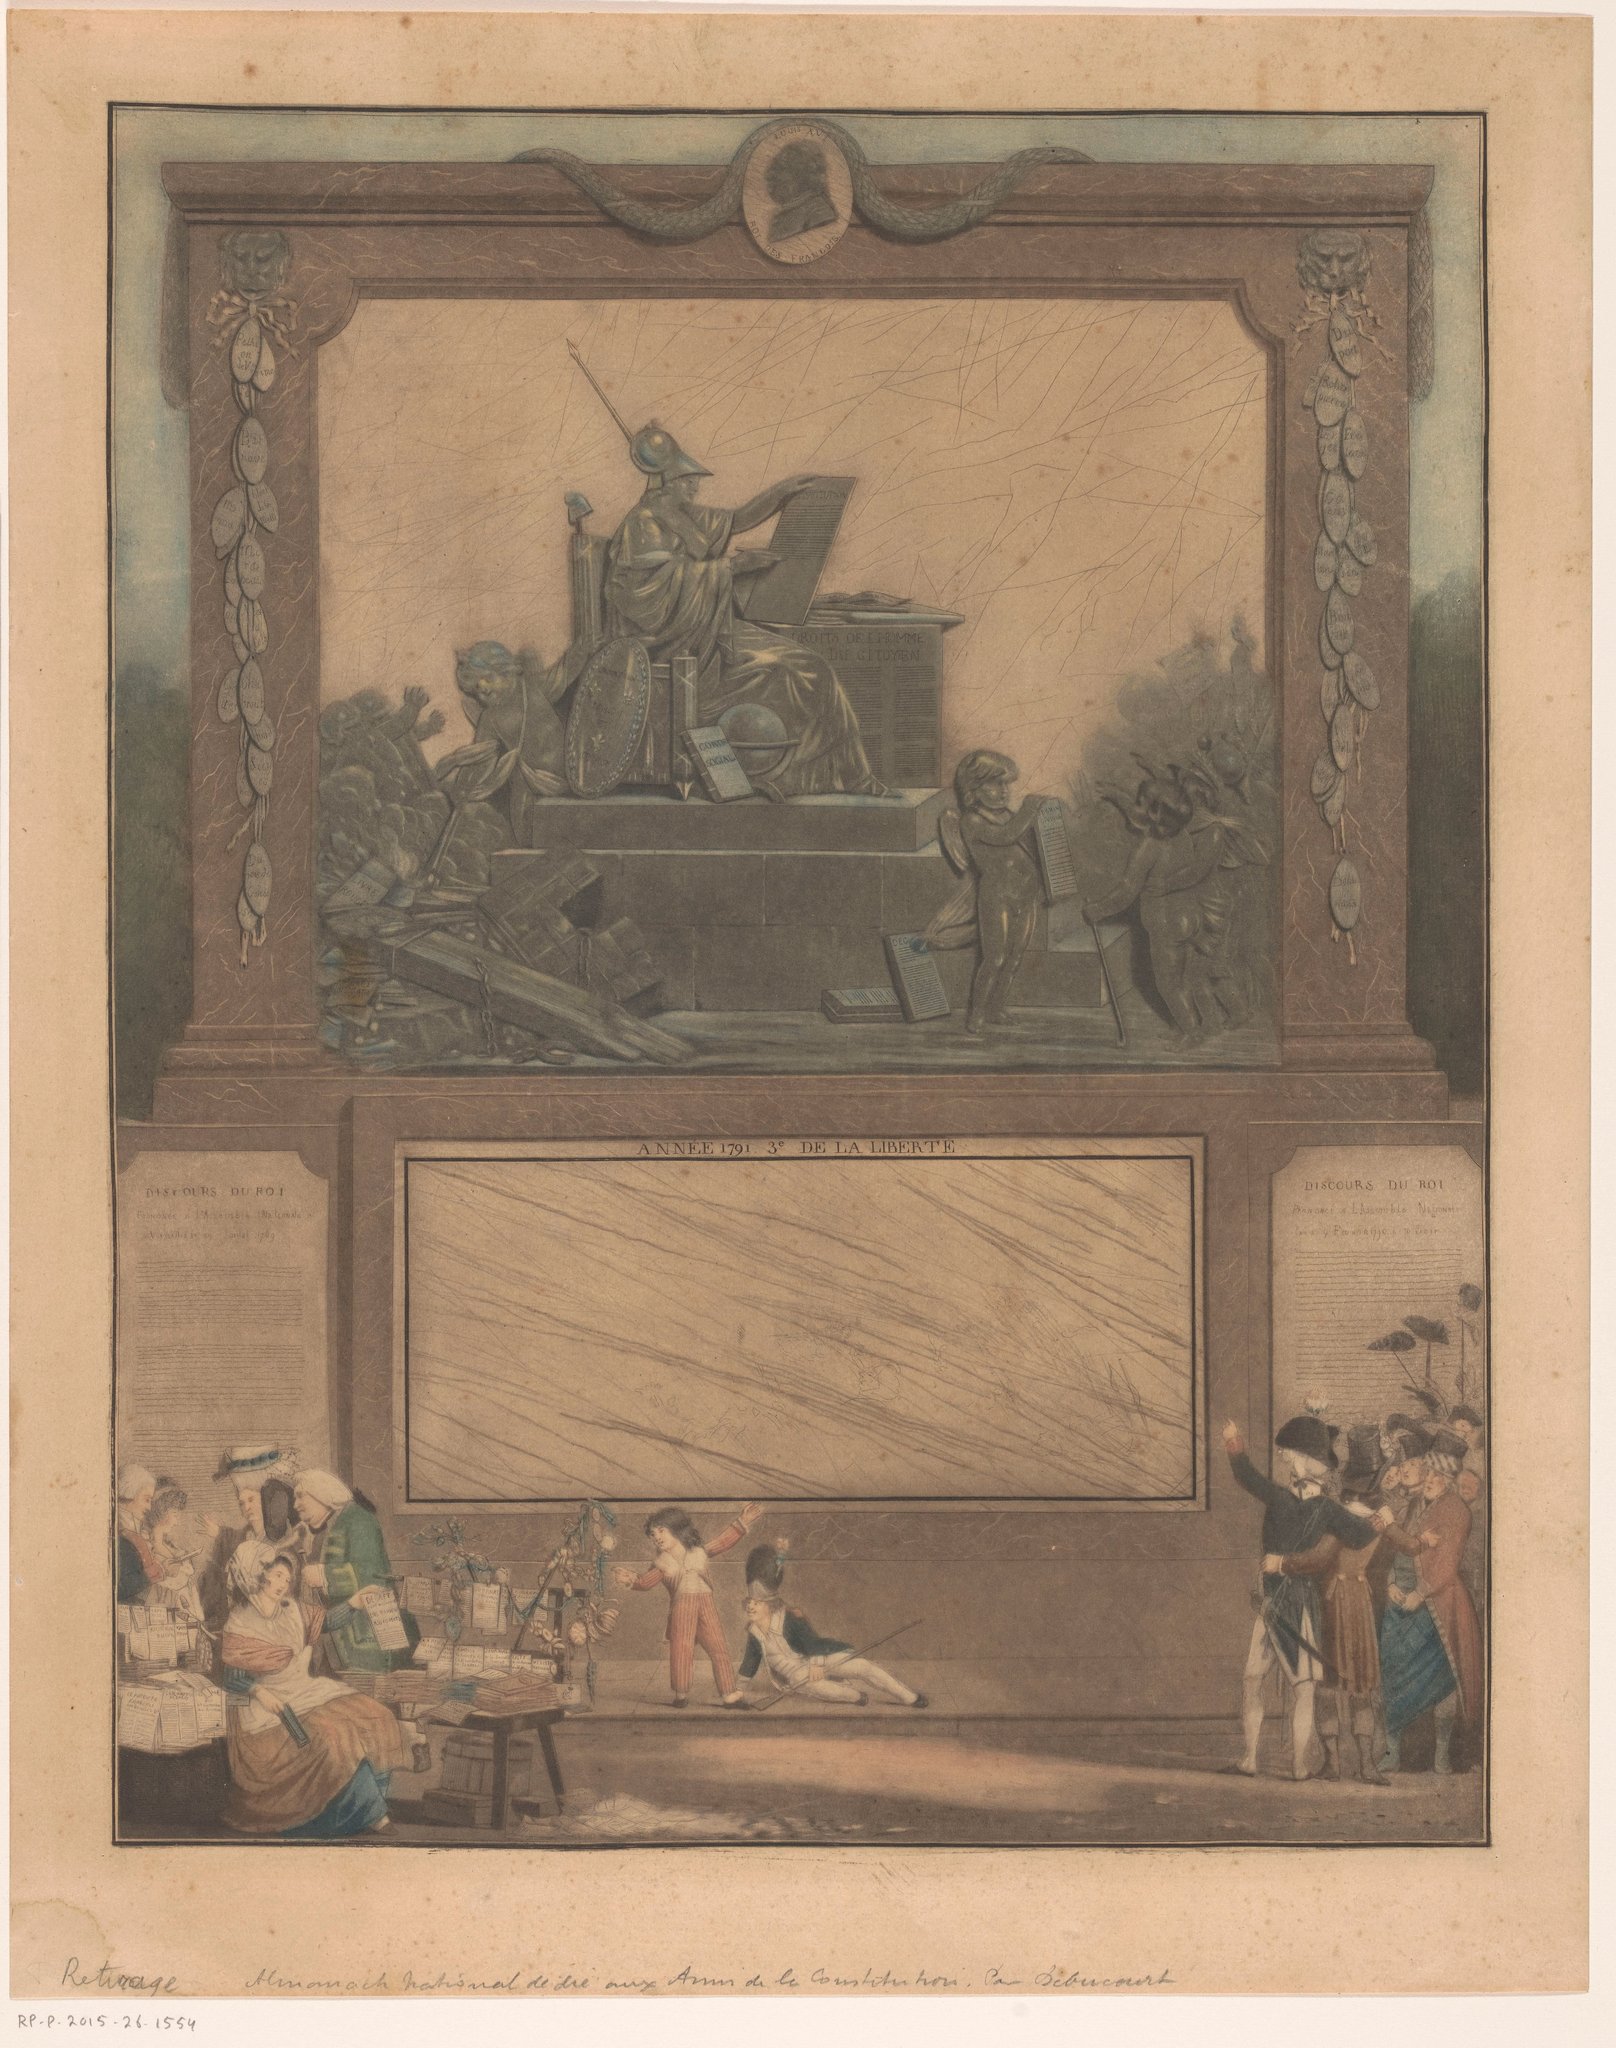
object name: print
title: Allegorie op de de Franse grondwet van 1791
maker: philibert-louis debucourt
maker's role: painter, print maker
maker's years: 1755-1832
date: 1791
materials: paper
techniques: etching, roulette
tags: lodewijk xvi (koning van frankrijk), distributing pamphlets, book-stall, kiosk, street-trader, specific aspects, allegorical aspects of minerva; minerva as patroness, cupids: 'amores', 'amoretti', 'putti'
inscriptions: collector's mark: Lugt 4779, annotation: ‘Retirage Almanach National dédié aux Amis de la Constitution par Debucourt’, collector's mark: Lugt 4780, collector's mark: Lugt 2228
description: Architecturale omlijsting met bovenin het portret van Lodewijk XVI van Frankrijk. Daaronder zit Minerva op een stoel, schrijvend aan de grondwet van 1791, Zij wordt omringd door putti en verwijzingen naar de Franse Revolutie zoals gebroken ketenen en teksten als het 'Contrat social' en de 'Déclaration des droits de l'homme et du citoyen'. Voor het monument links verkoopt een vrouw nieuwsbladen en pamfletten. Rechts staat een groepje revolutionairen.